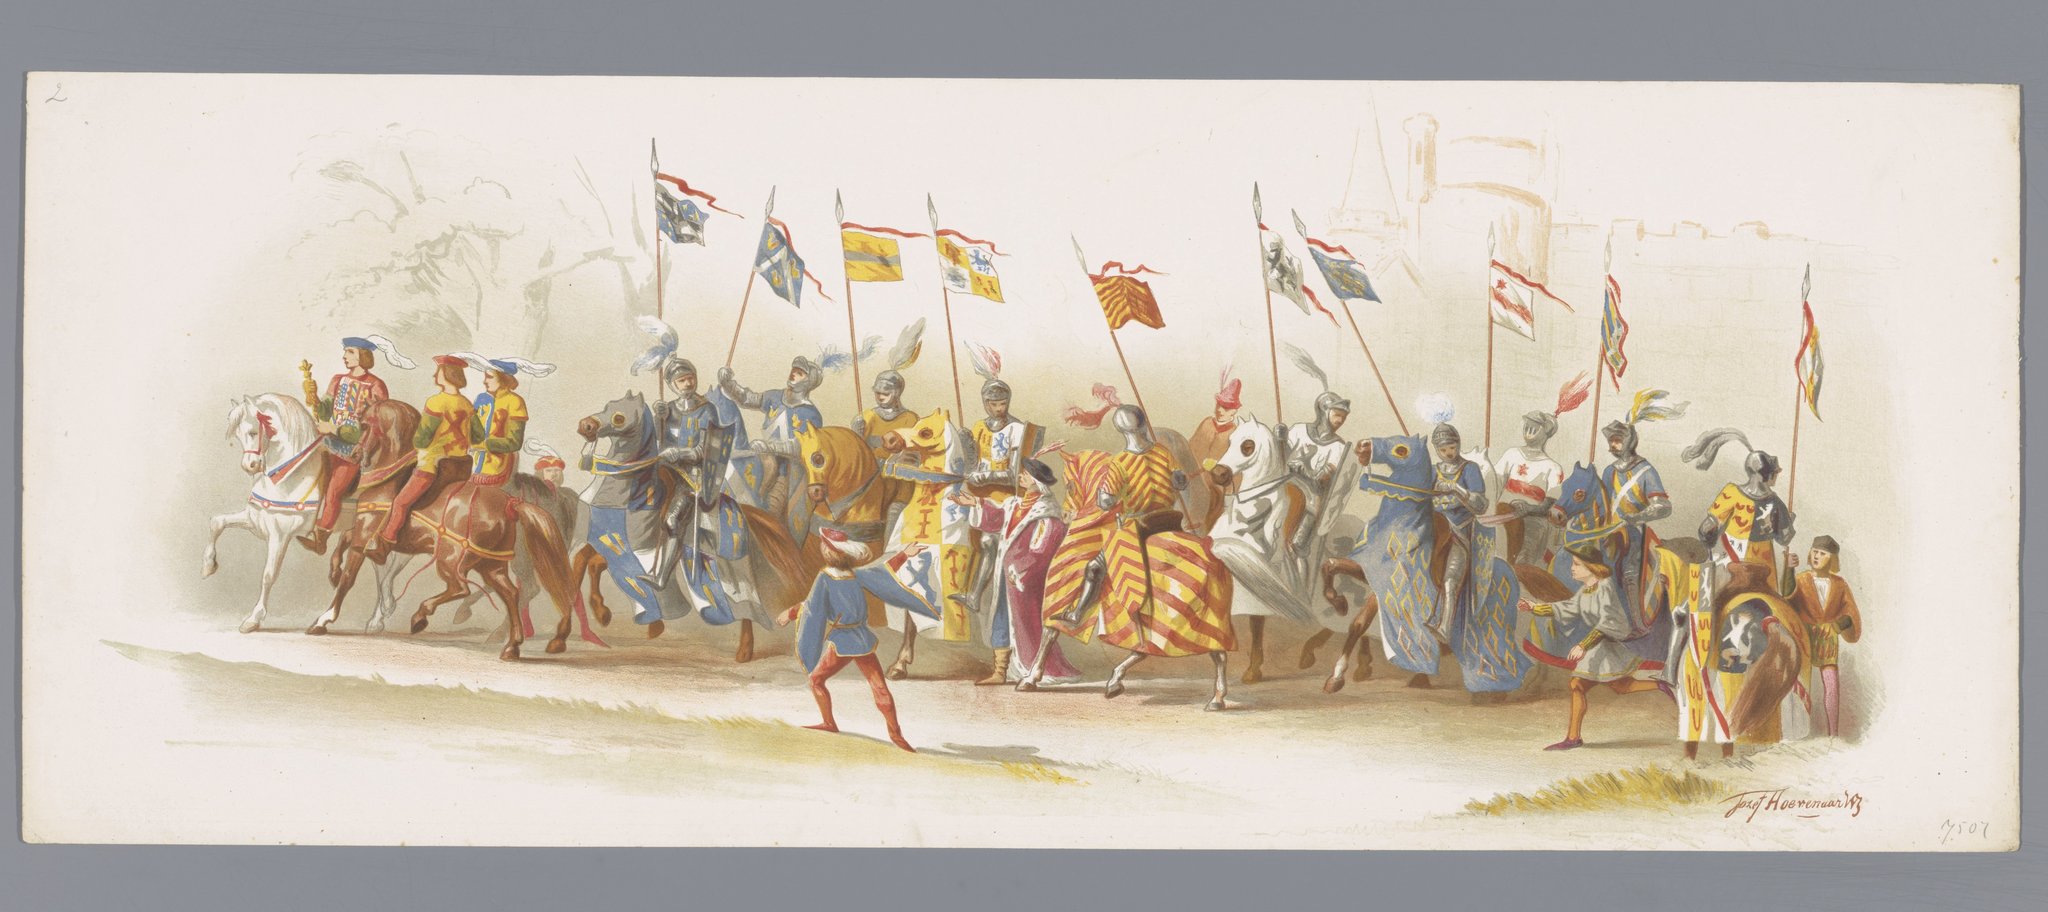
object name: print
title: XLVIII. Lustrum der Utrechtsche Hoogeschool. Intocht van Hertog Karel den Stoute te Zutfen, IV Augustus MCCCCLXXIII. Gekostumeerde optocht van Heeren Studenten, gehouden te Utrecht den 27 Juni 1876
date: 1876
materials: paper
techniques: chromolithography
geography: amsterdam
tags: charles the bold (duke of burgundy), students' pageant, costumes used in pageants, commemoration of the founding of a university, utrecht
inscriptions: collector's mark: Lugt 2228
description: Tweede deel van de optocht. Onderdeel van een serie van zeven platen plus titelprent en verklaring van de gecostumeerde optocht georganiseerd door de studenten van de Utrechtse Hogeschool ter viering van de 48e lustrum op 27 juni 1876. De optocht stelt voor de intocht van Karel te Stoute te Zutphen op 4 augustus 1473.